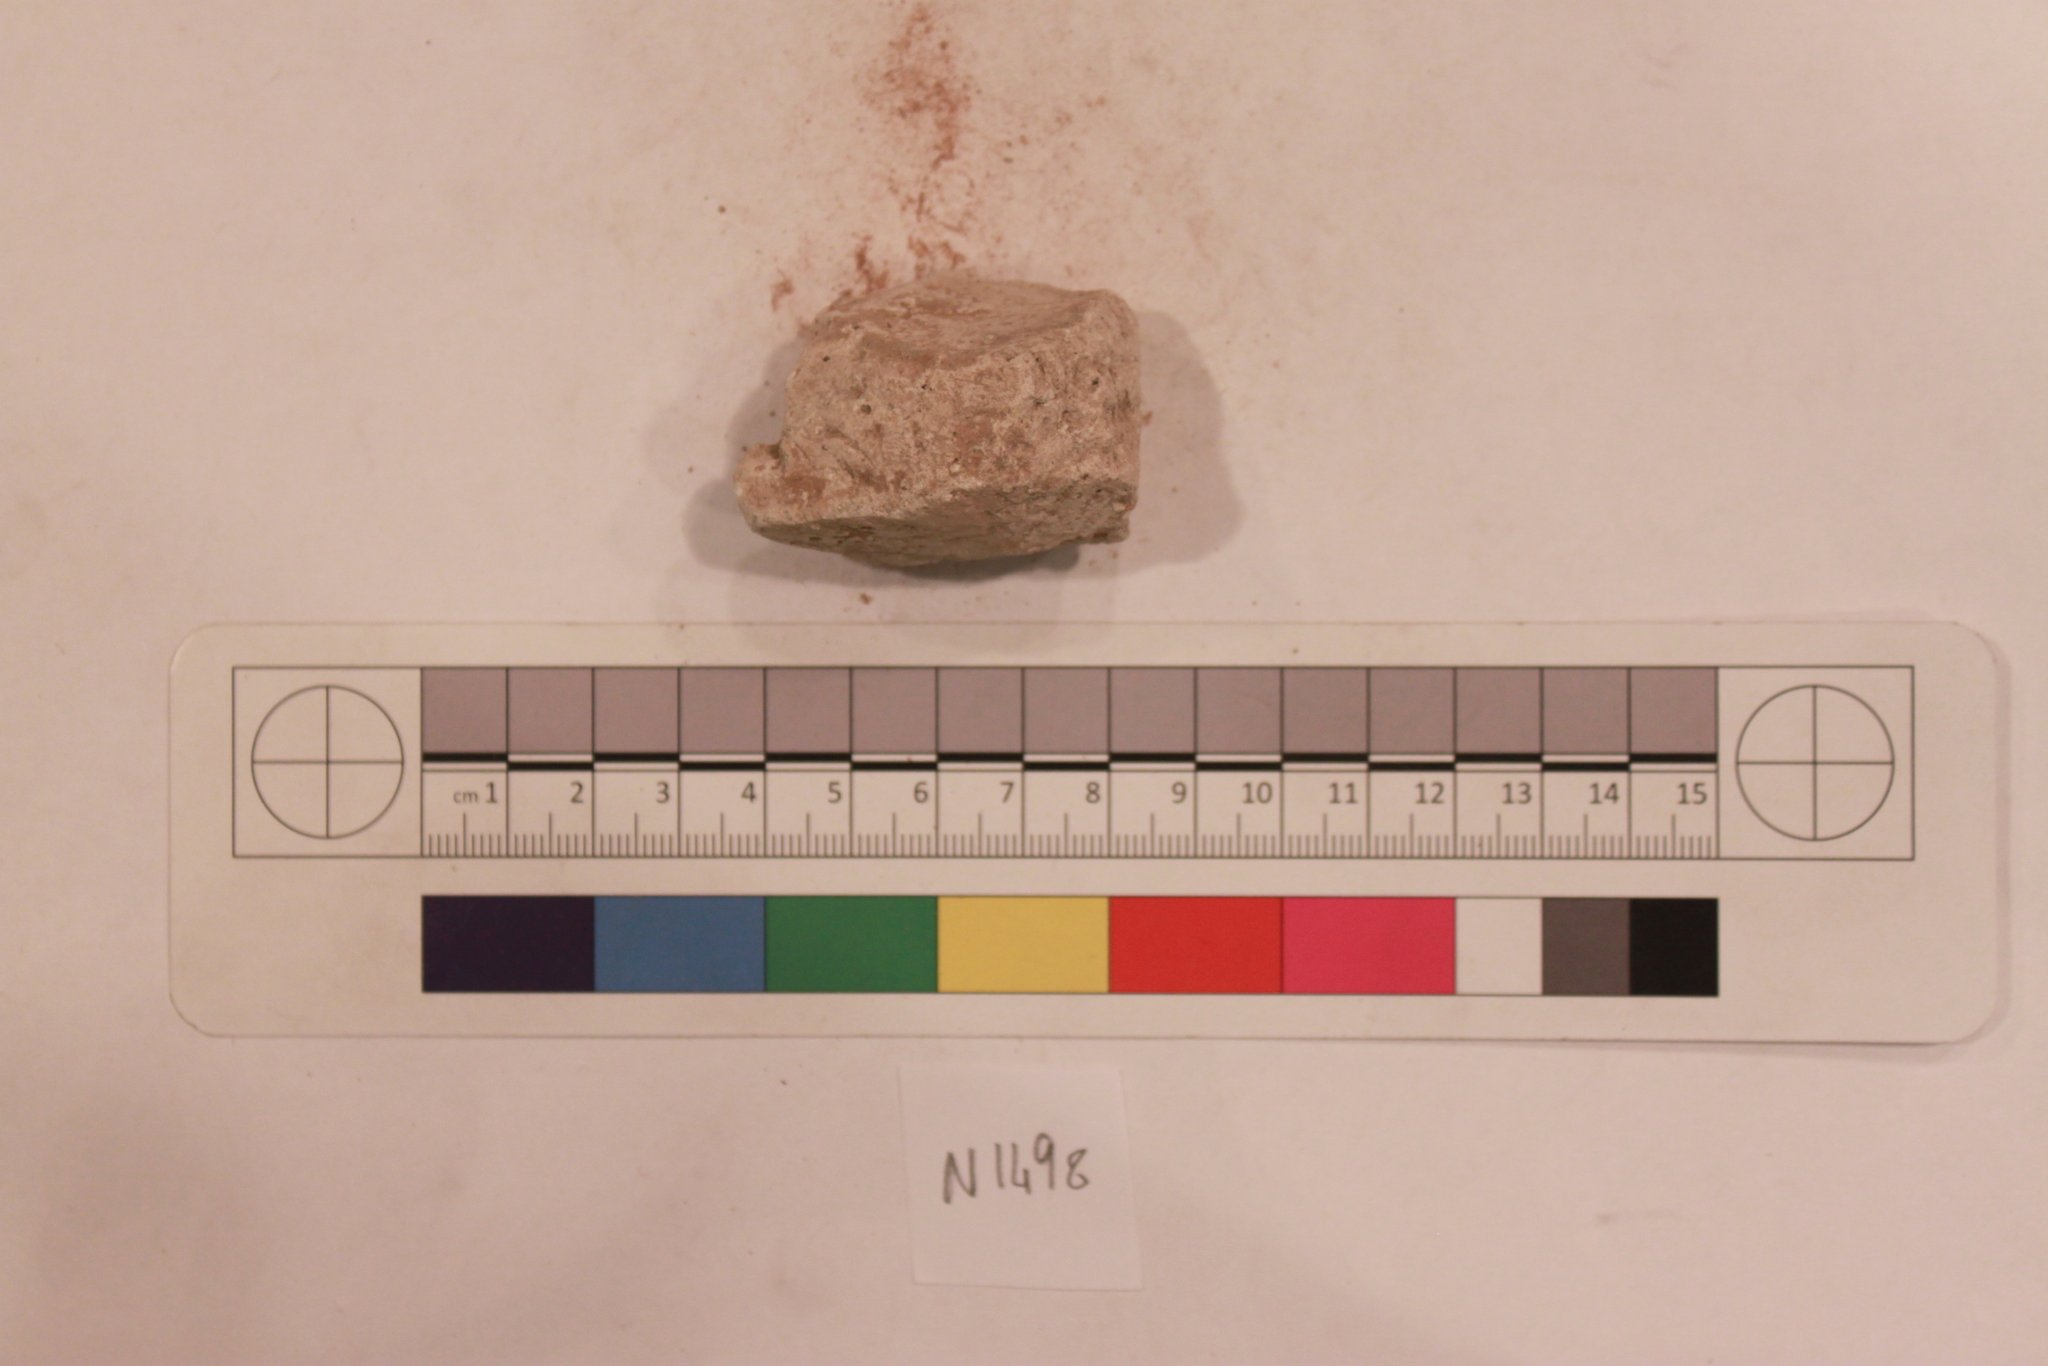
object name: fragment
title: Stucco Fragment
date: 701-1200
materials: plaster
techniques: carving, painting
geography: iran